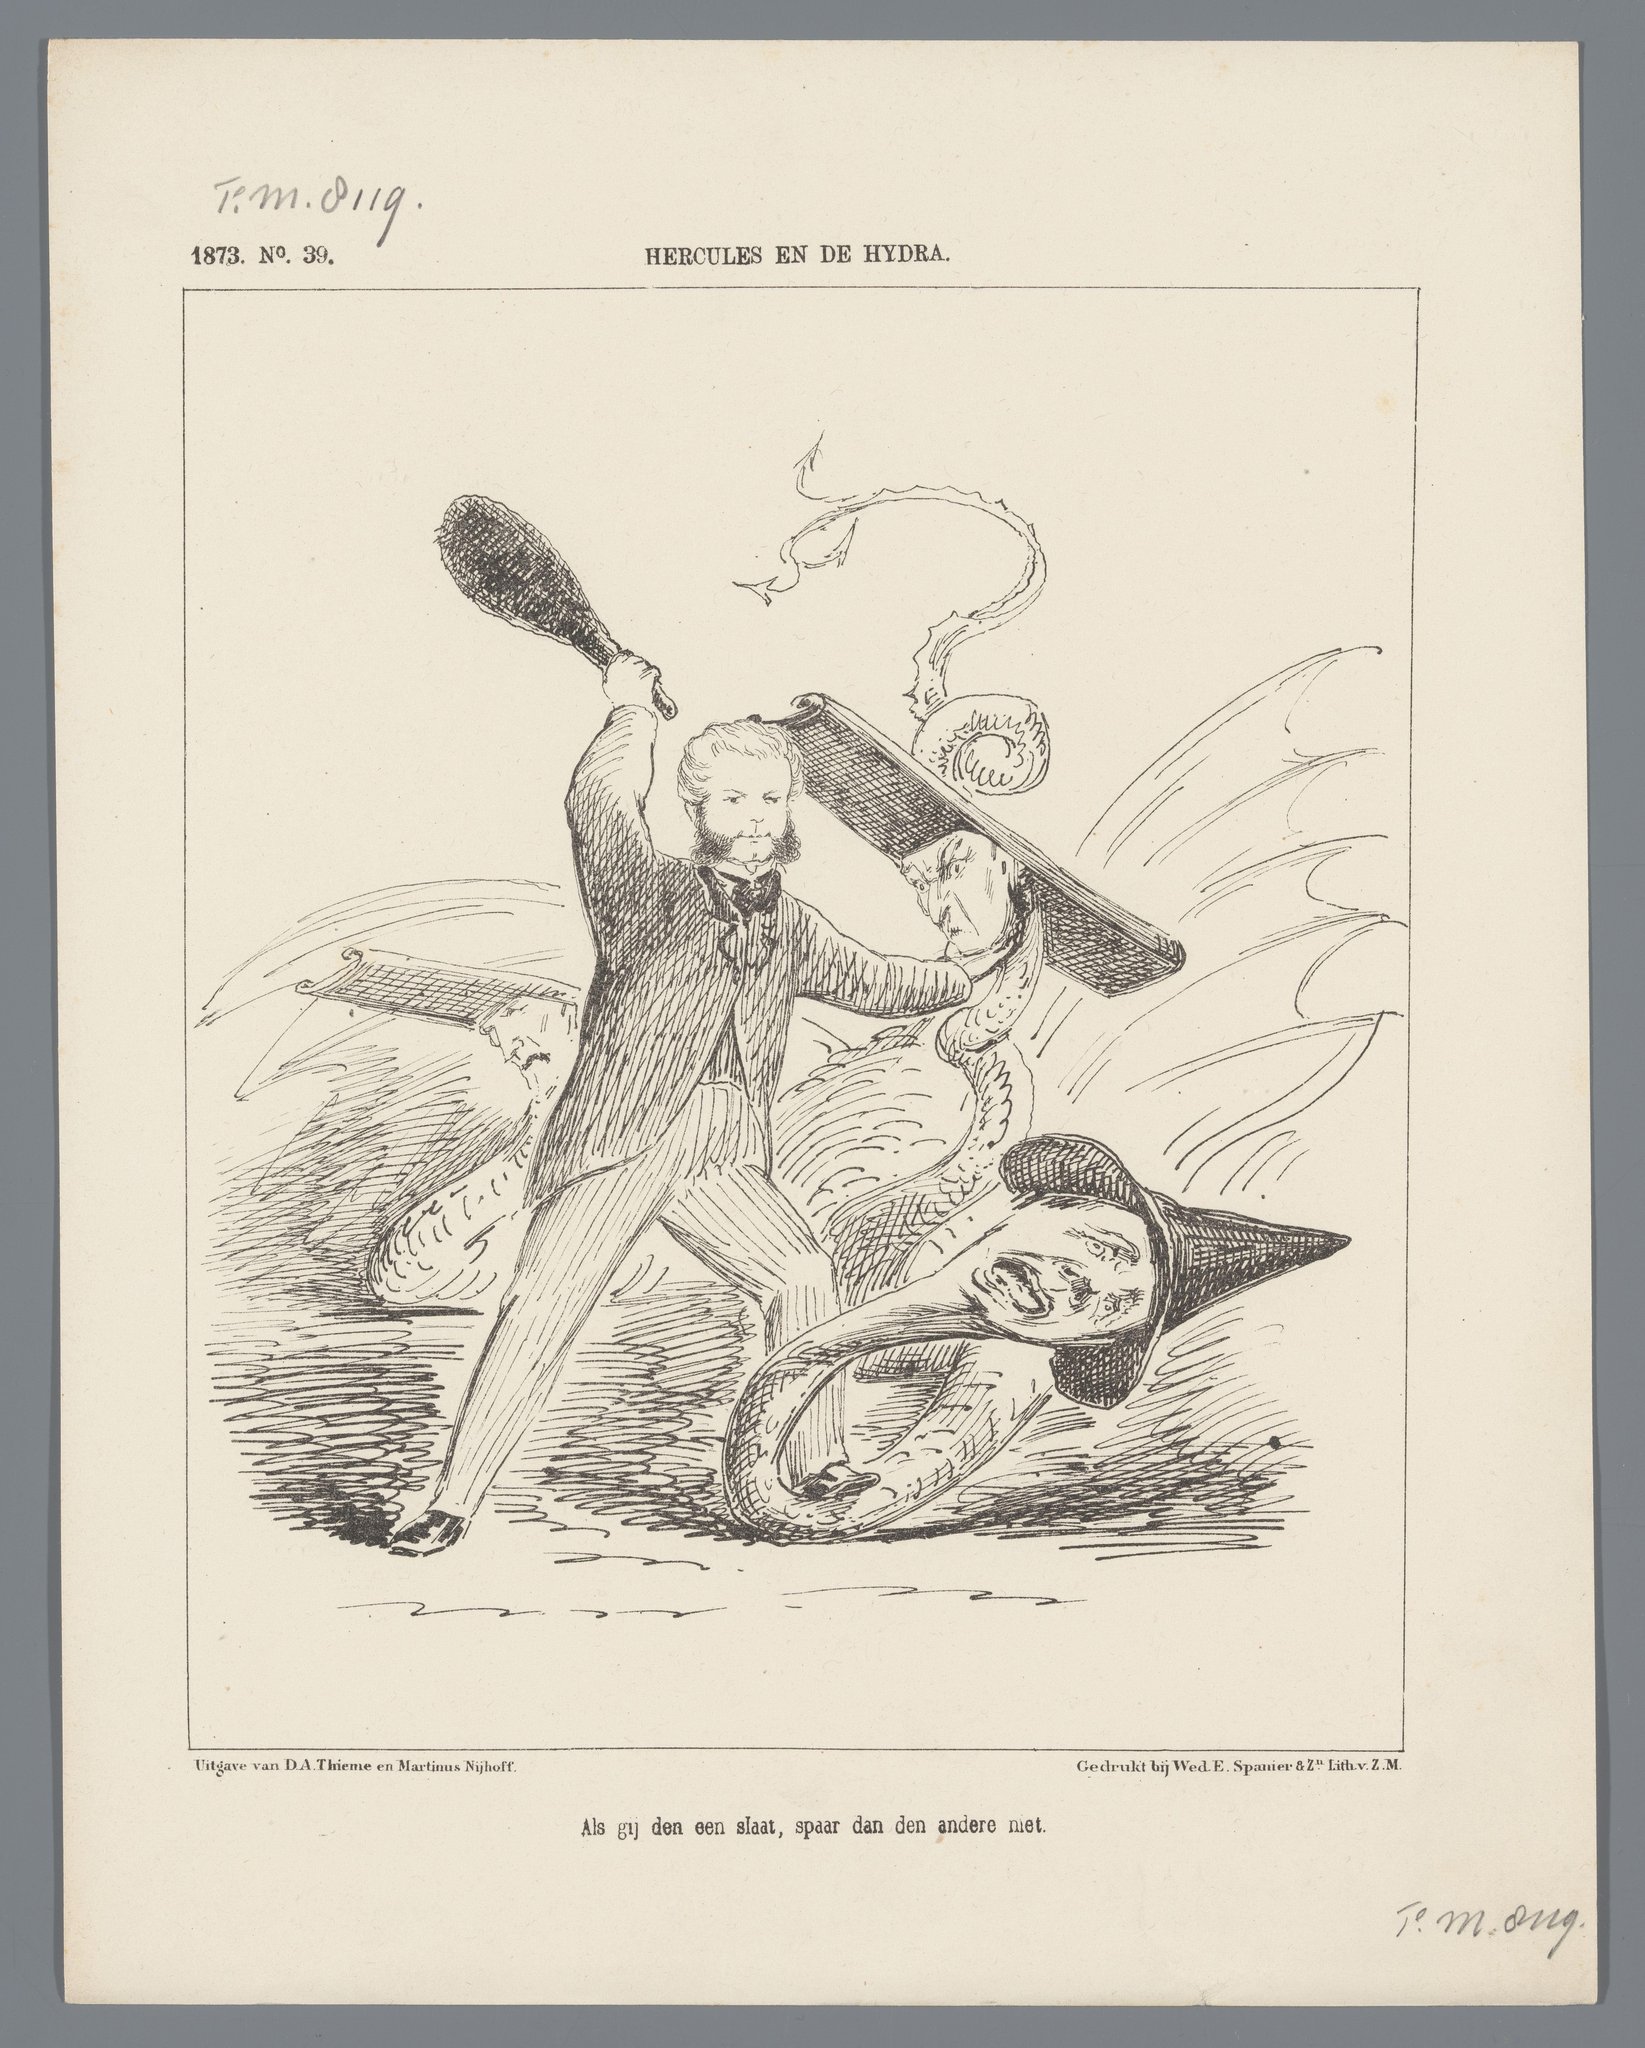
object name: cartoon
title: Hercules en de Hydra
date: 1873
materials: paper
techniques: lithograph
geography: netherlands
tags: politician, (story of) hercules (heracles)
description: Spotprent op de rede van kamerlid Willem Wintgens, voorgesteld als Hercules, op 22 september 1873 waarbij hij de antirevolutionairen aanviel en de katholieken spaarde. Plaat verschenen bij het weekblad De Nederlandsche Spectator, nr. 39, 1873.